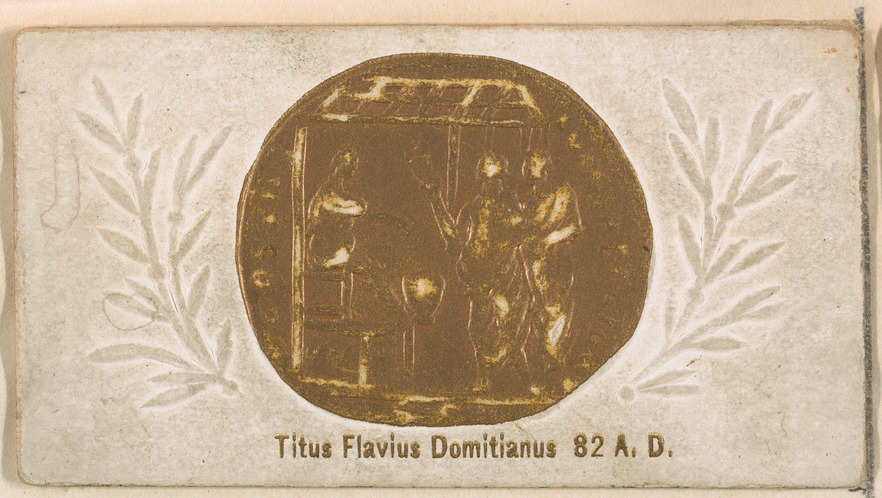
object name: print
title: Titus Flavius Domitianus, 82 A.D., from the Ancient Coins series (N180) issued by Wm. S. Kimball & Co.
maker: william s. kimball & company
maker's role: publisher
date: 1888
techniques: color lithograph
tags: coins